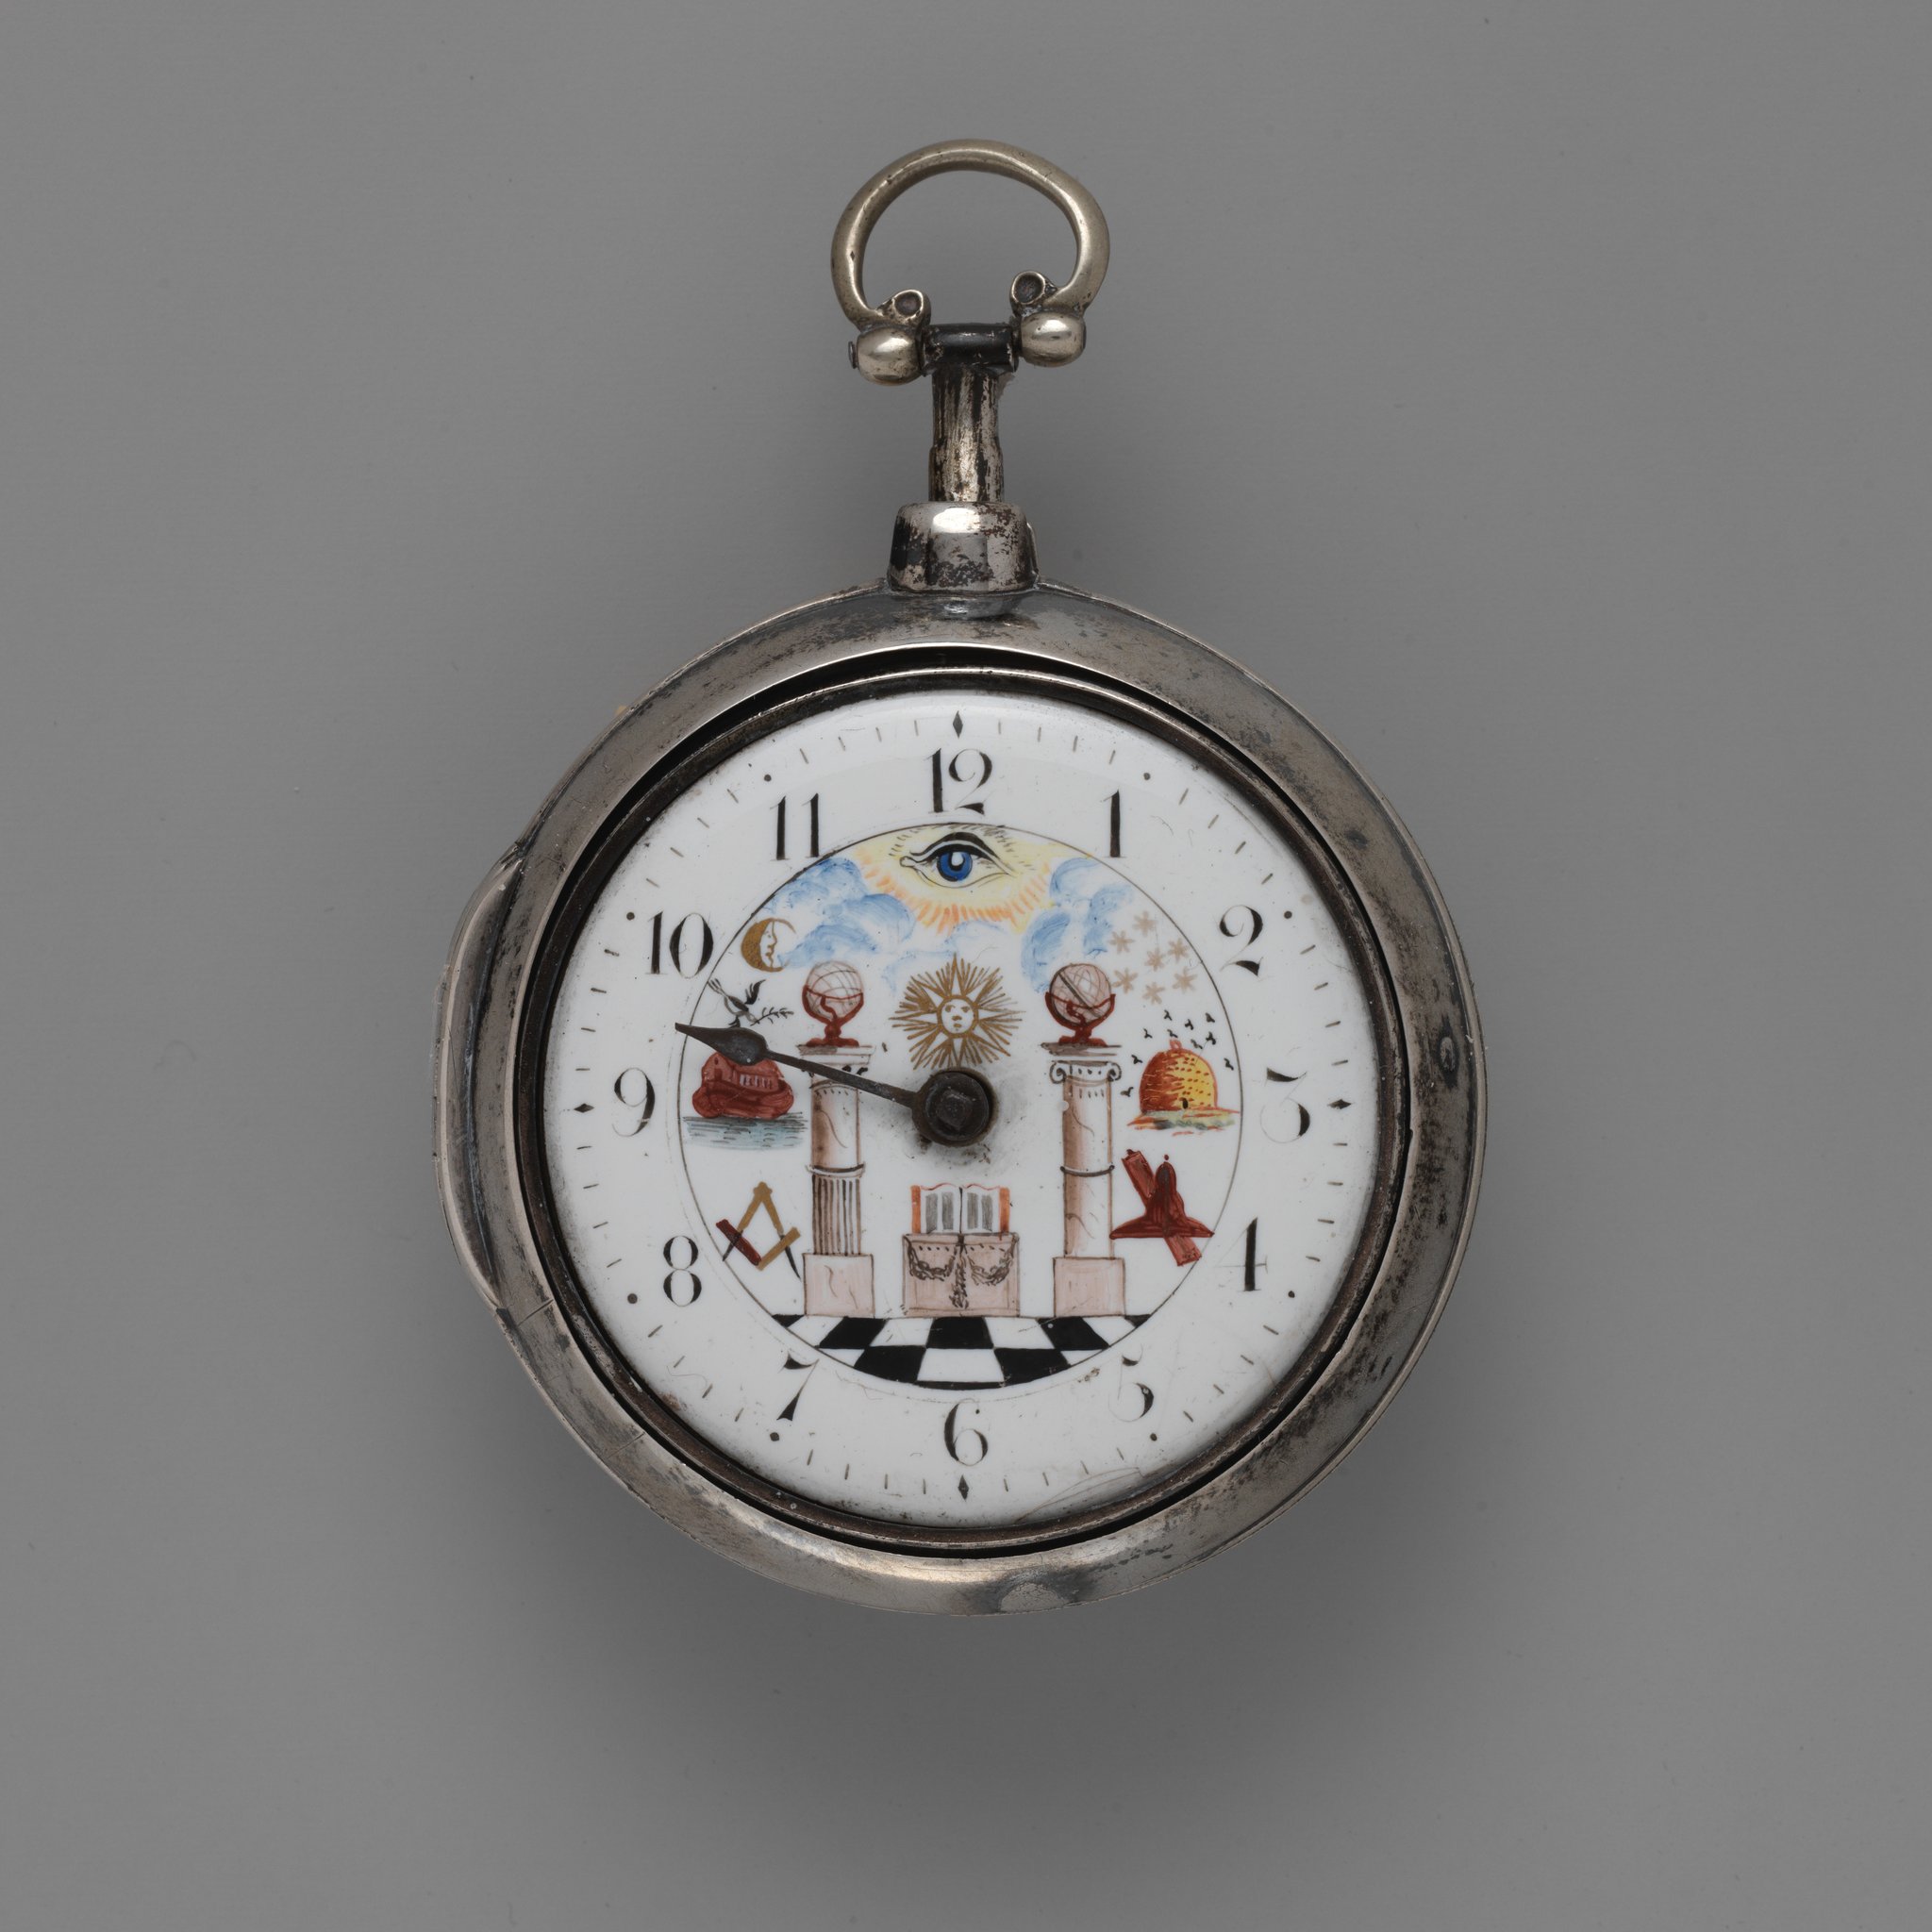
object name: watch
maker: d. edmonds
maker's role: maker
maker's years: 1787-1810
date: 1767-1800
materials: silver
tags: eyes,sun,globes